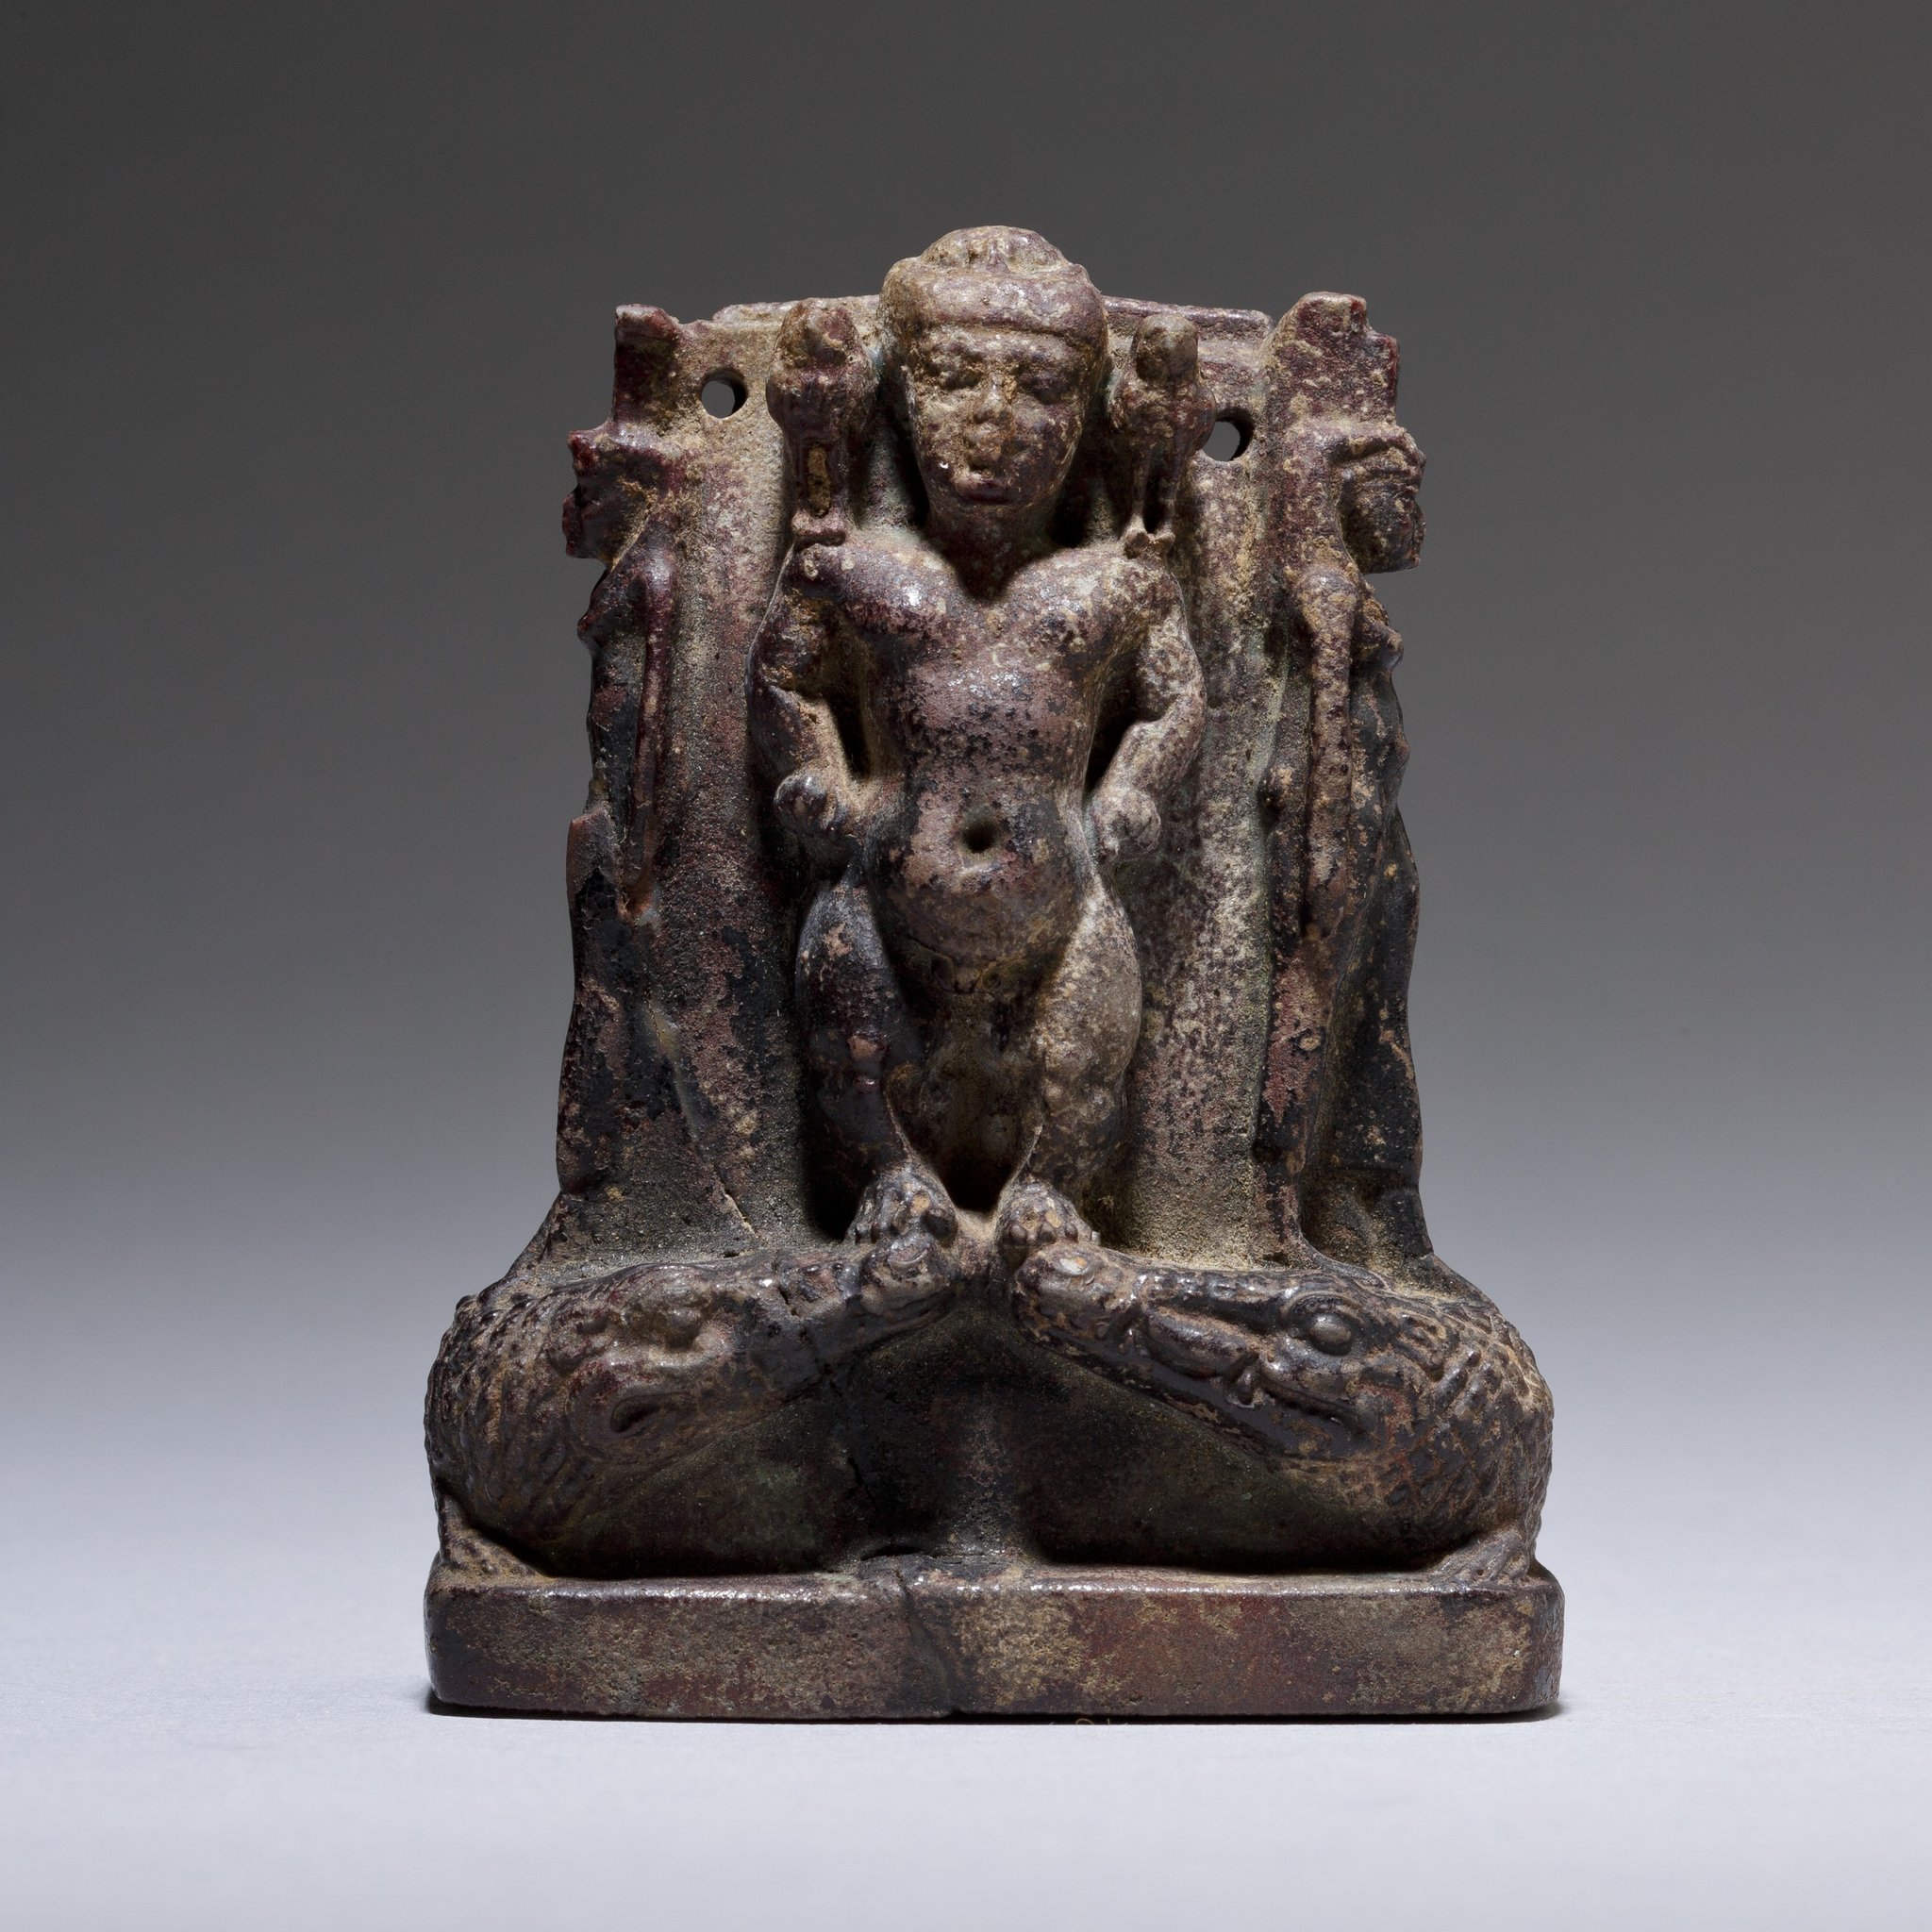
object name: cippus, pataikos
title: Cippus (magical stela) where Pataikos replaces Horus on the crocodiles and is flanked by Isis and Nephthys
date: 1070-525 BCE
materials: faience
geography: egypt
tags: horus,isis,crocodiles